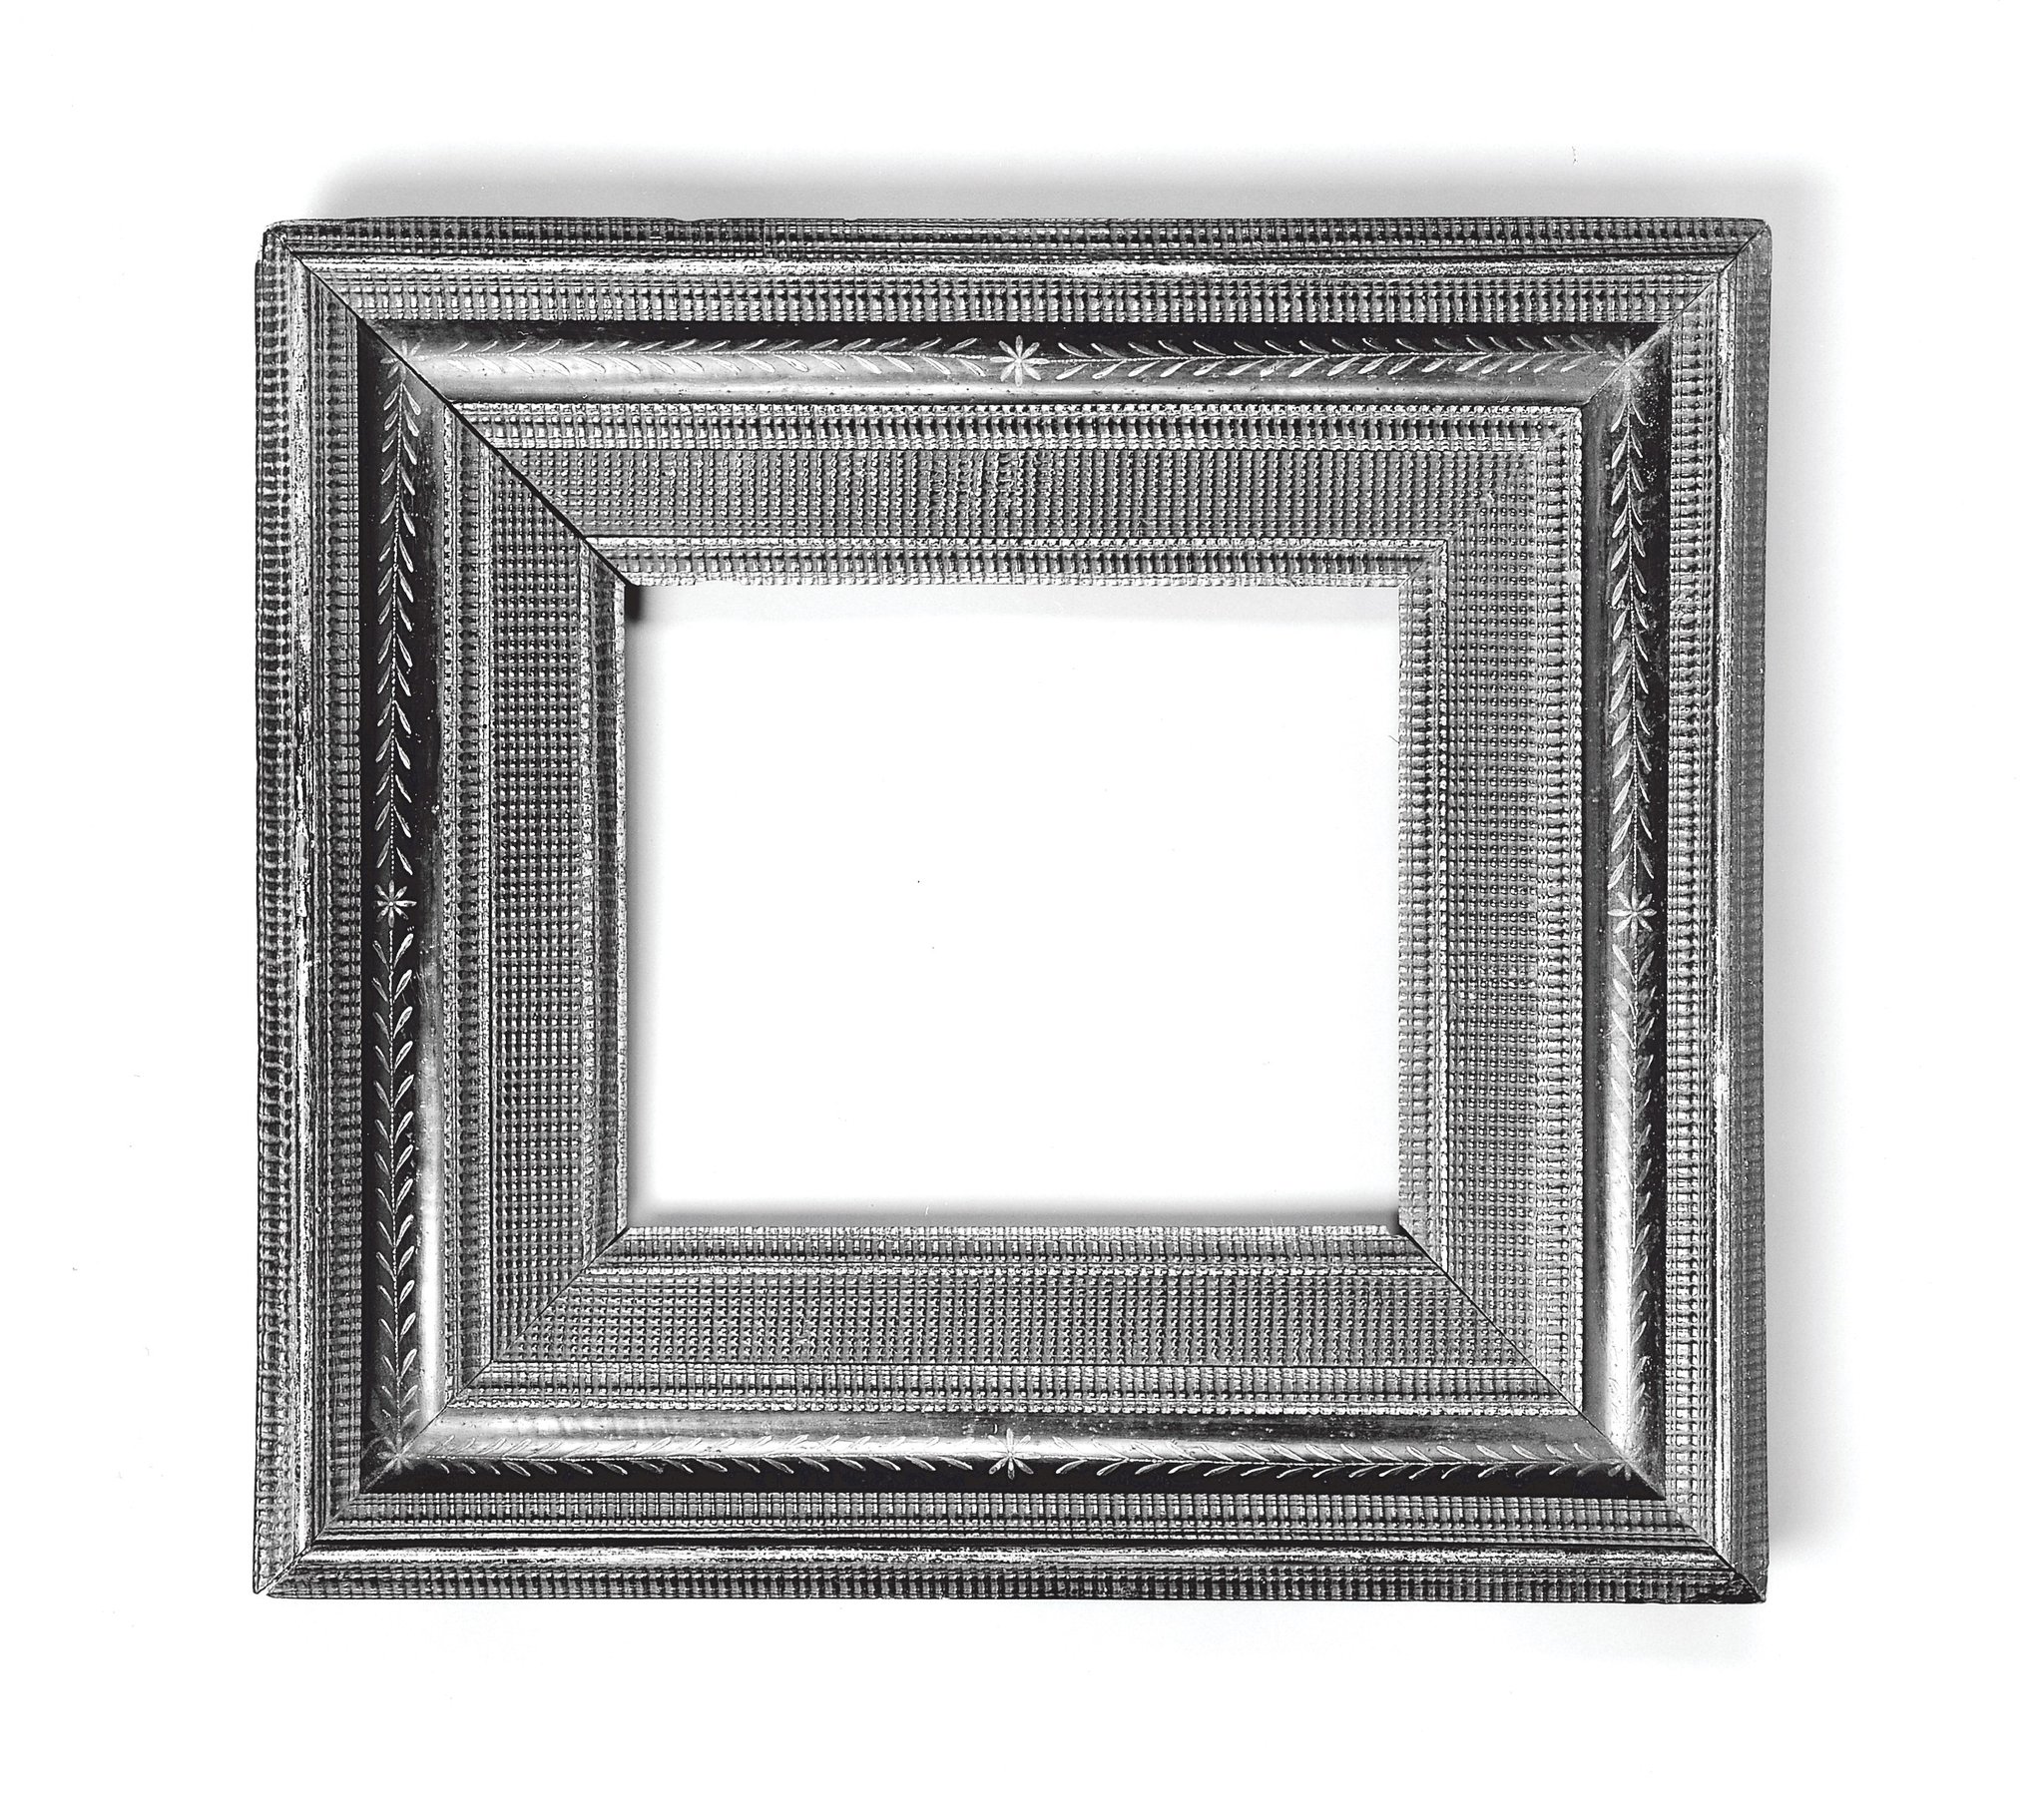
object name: frame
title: Hollow ripple frame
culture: german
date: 1667-1700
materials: wood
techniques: veneering